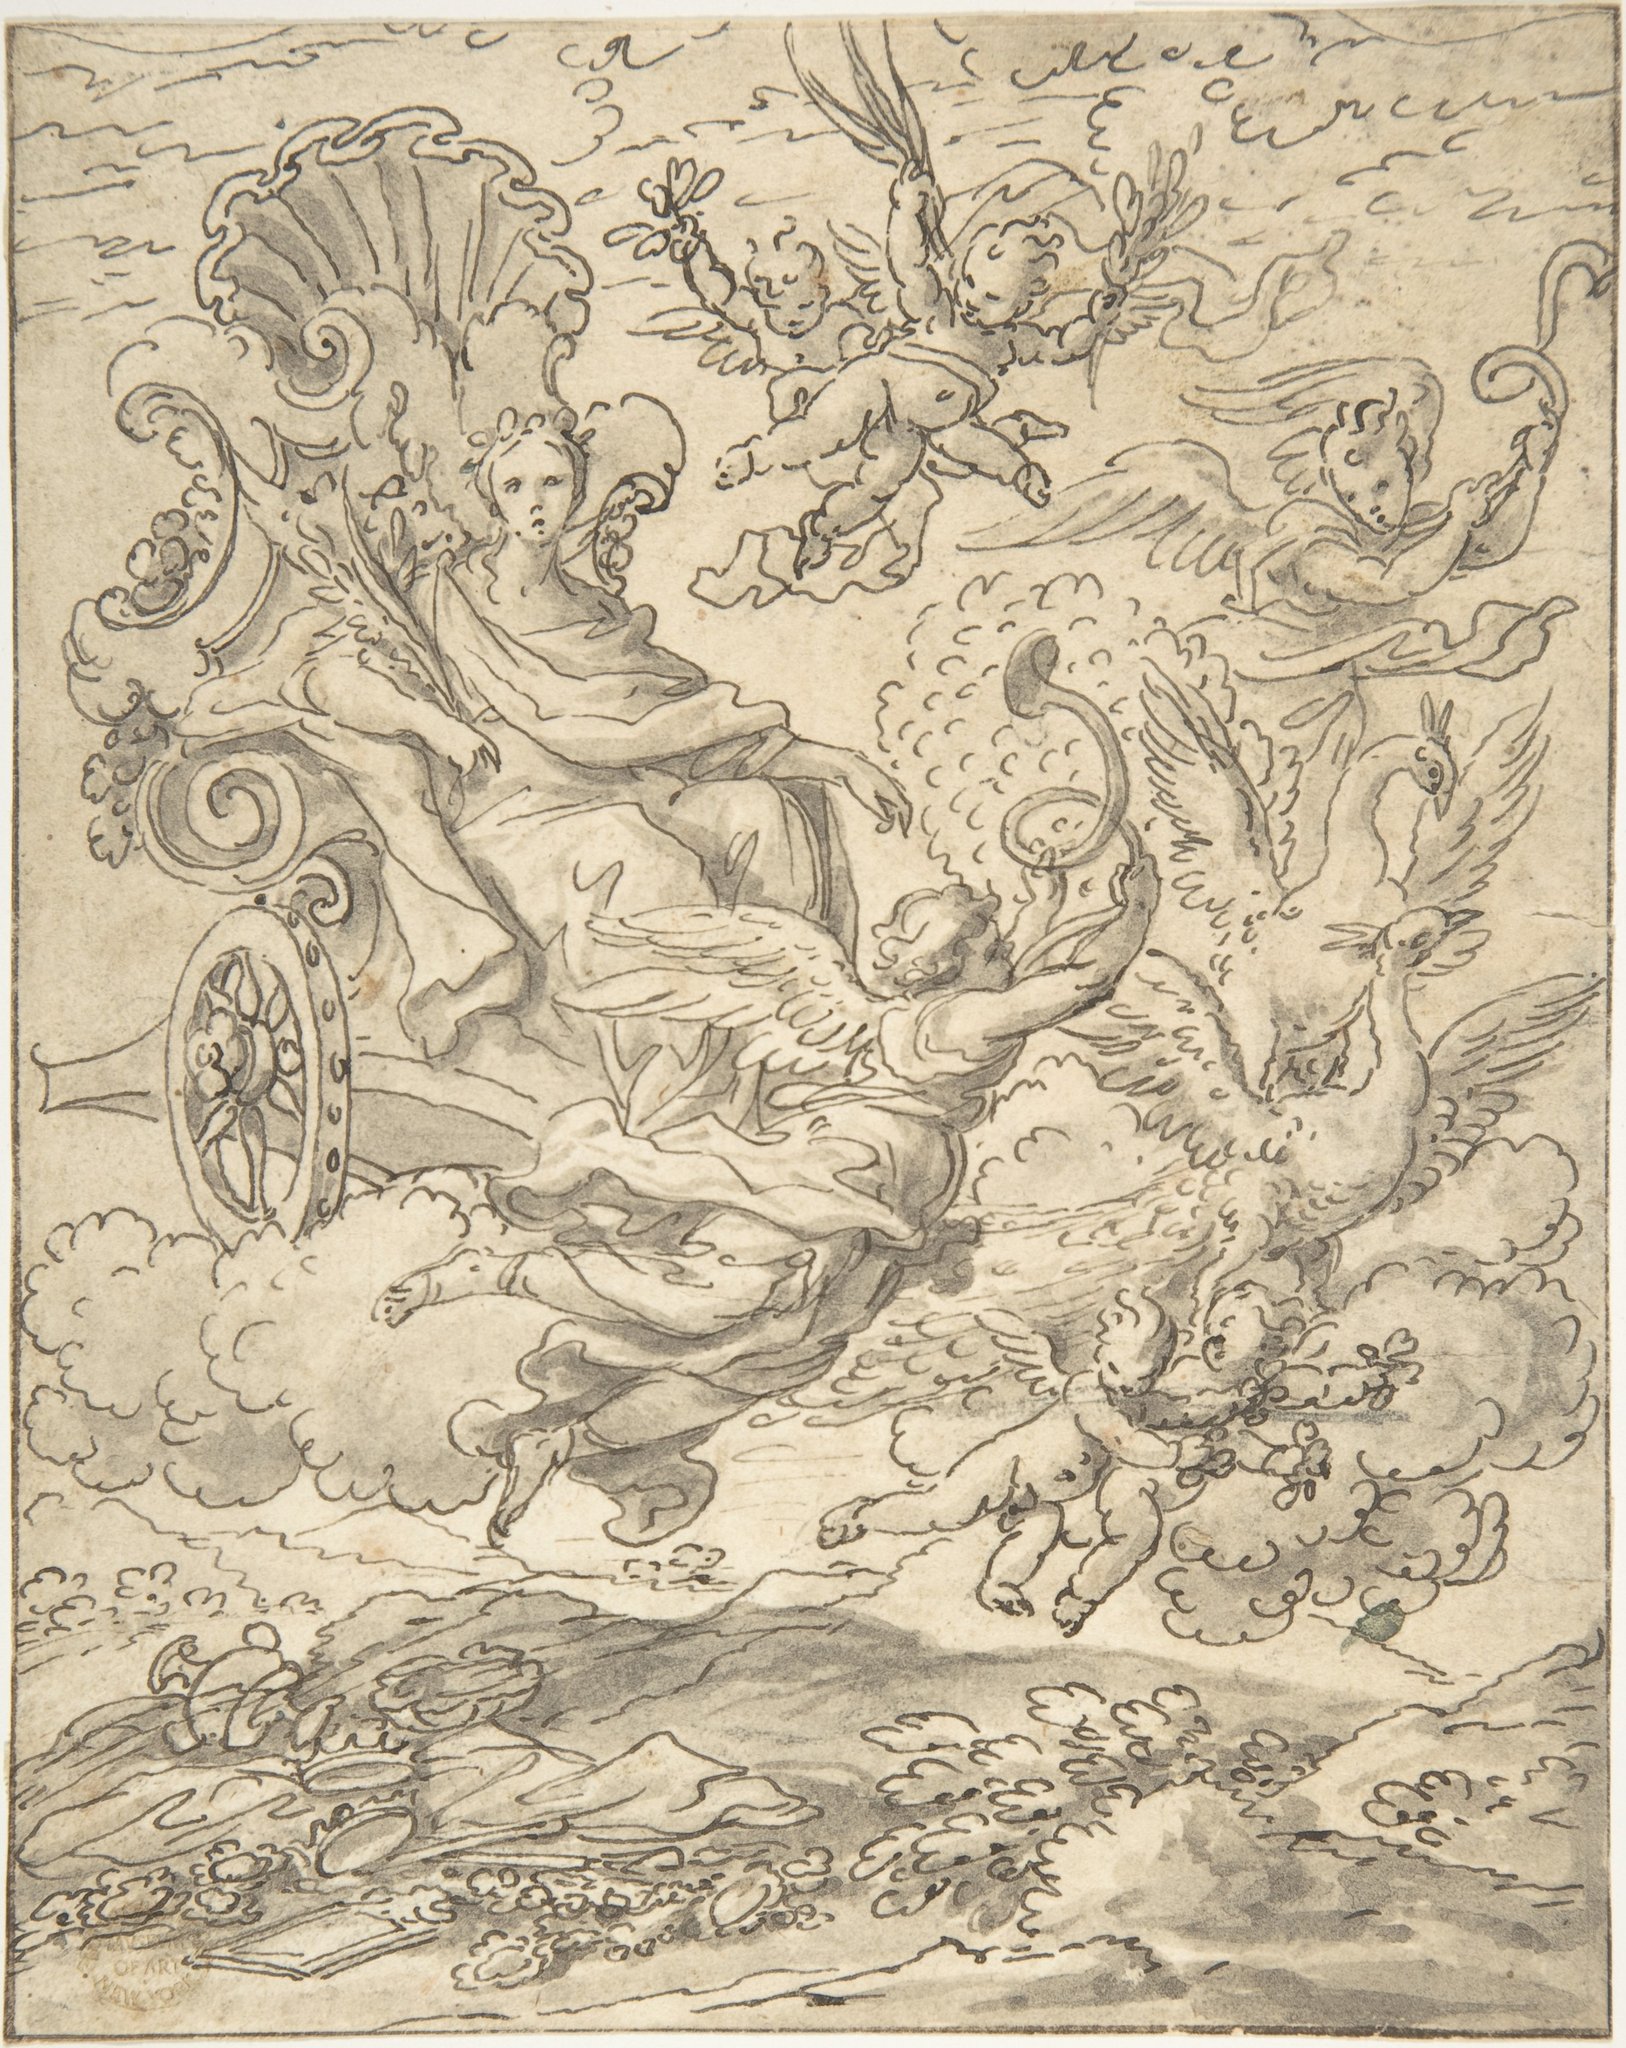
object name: drawing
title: Juno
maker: anonymous, italian, 18th century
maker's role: artist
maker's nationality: italian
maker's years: 1700-1800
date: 1701-1800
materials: chalk, ink, paper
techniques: brush, pen, wash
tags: birds,putti,juno,chariots